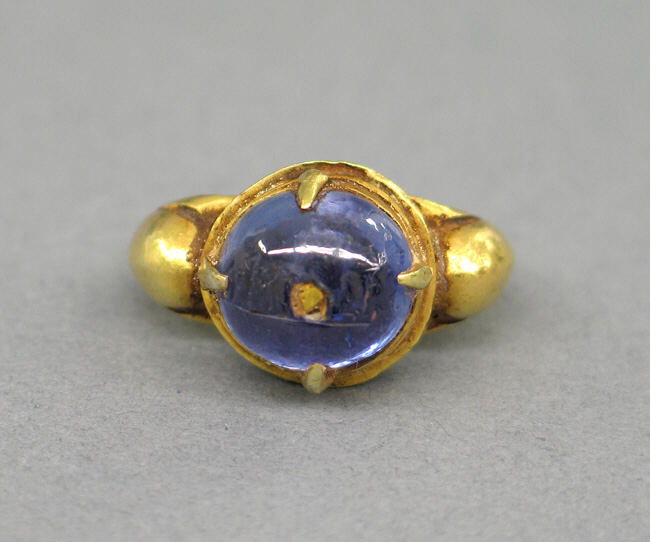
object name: ring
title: Ring with Blue Glass in Plain Setting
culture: indonesian, javanese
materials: glass, gold